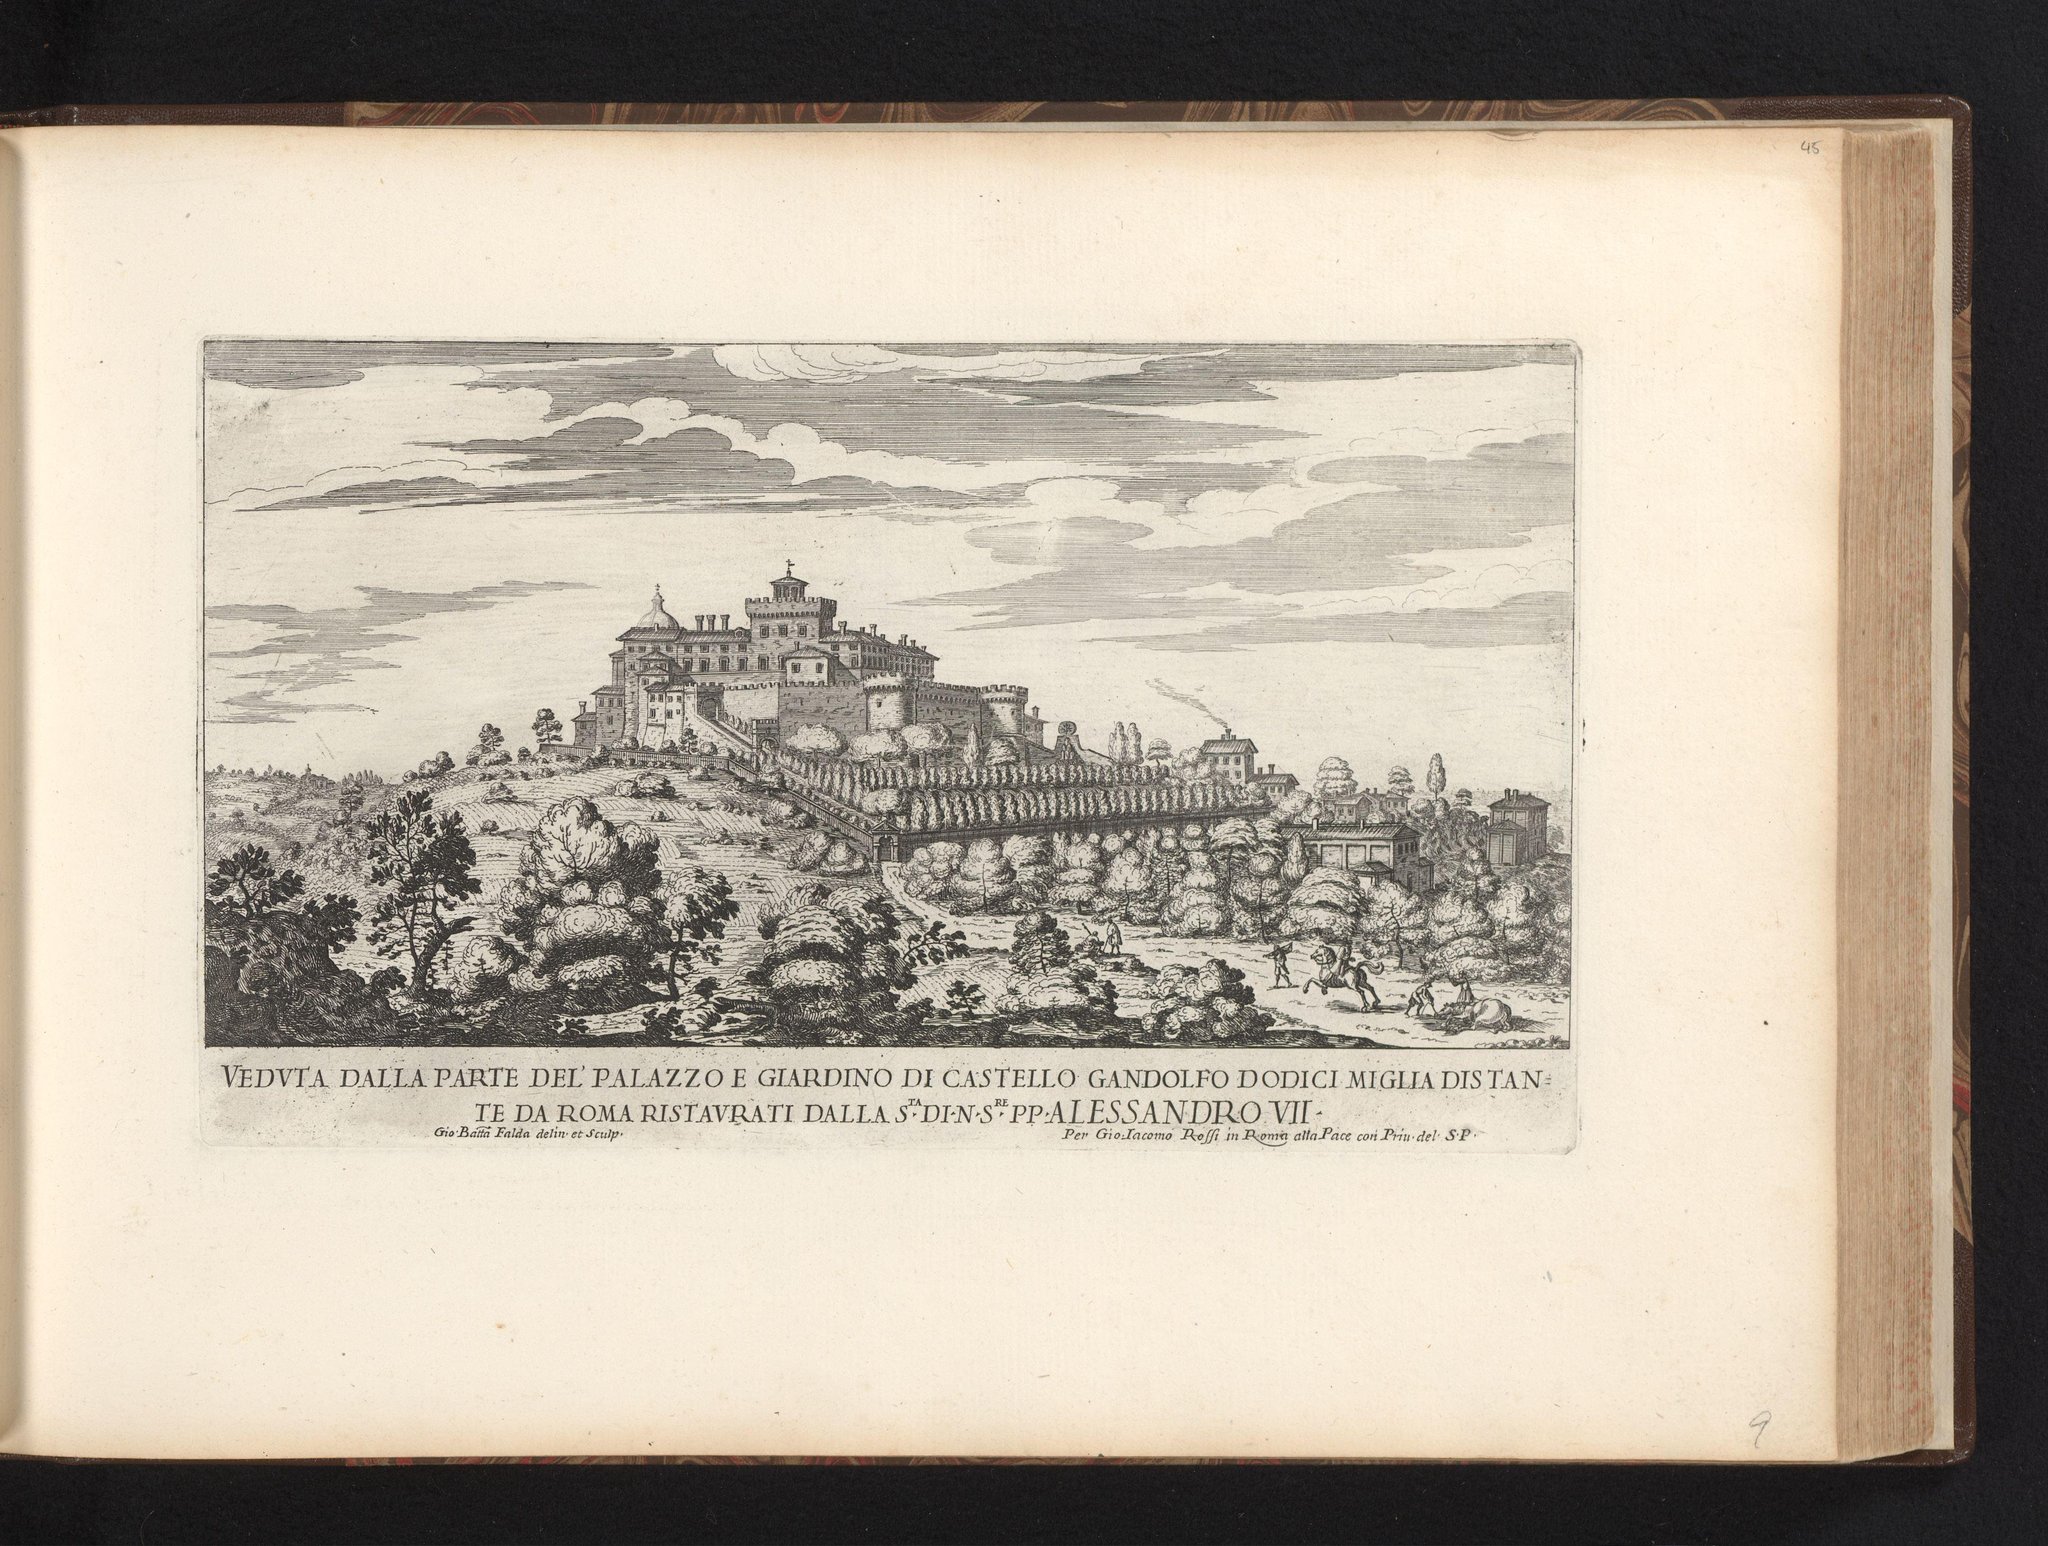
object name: print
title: Moderne gebouwen te Rome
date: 1665-1667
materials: paper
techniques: etching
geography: italy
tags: city-view, and landscape with man-made constructions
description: Deze prent maakt deel uit van een reeks van 17 prenten met voorstellingen van gebouwen in Rome. Samen met vier andere reeksen vormt het de grote reeks: 'Il nuovo teatro di Roma moderna'.